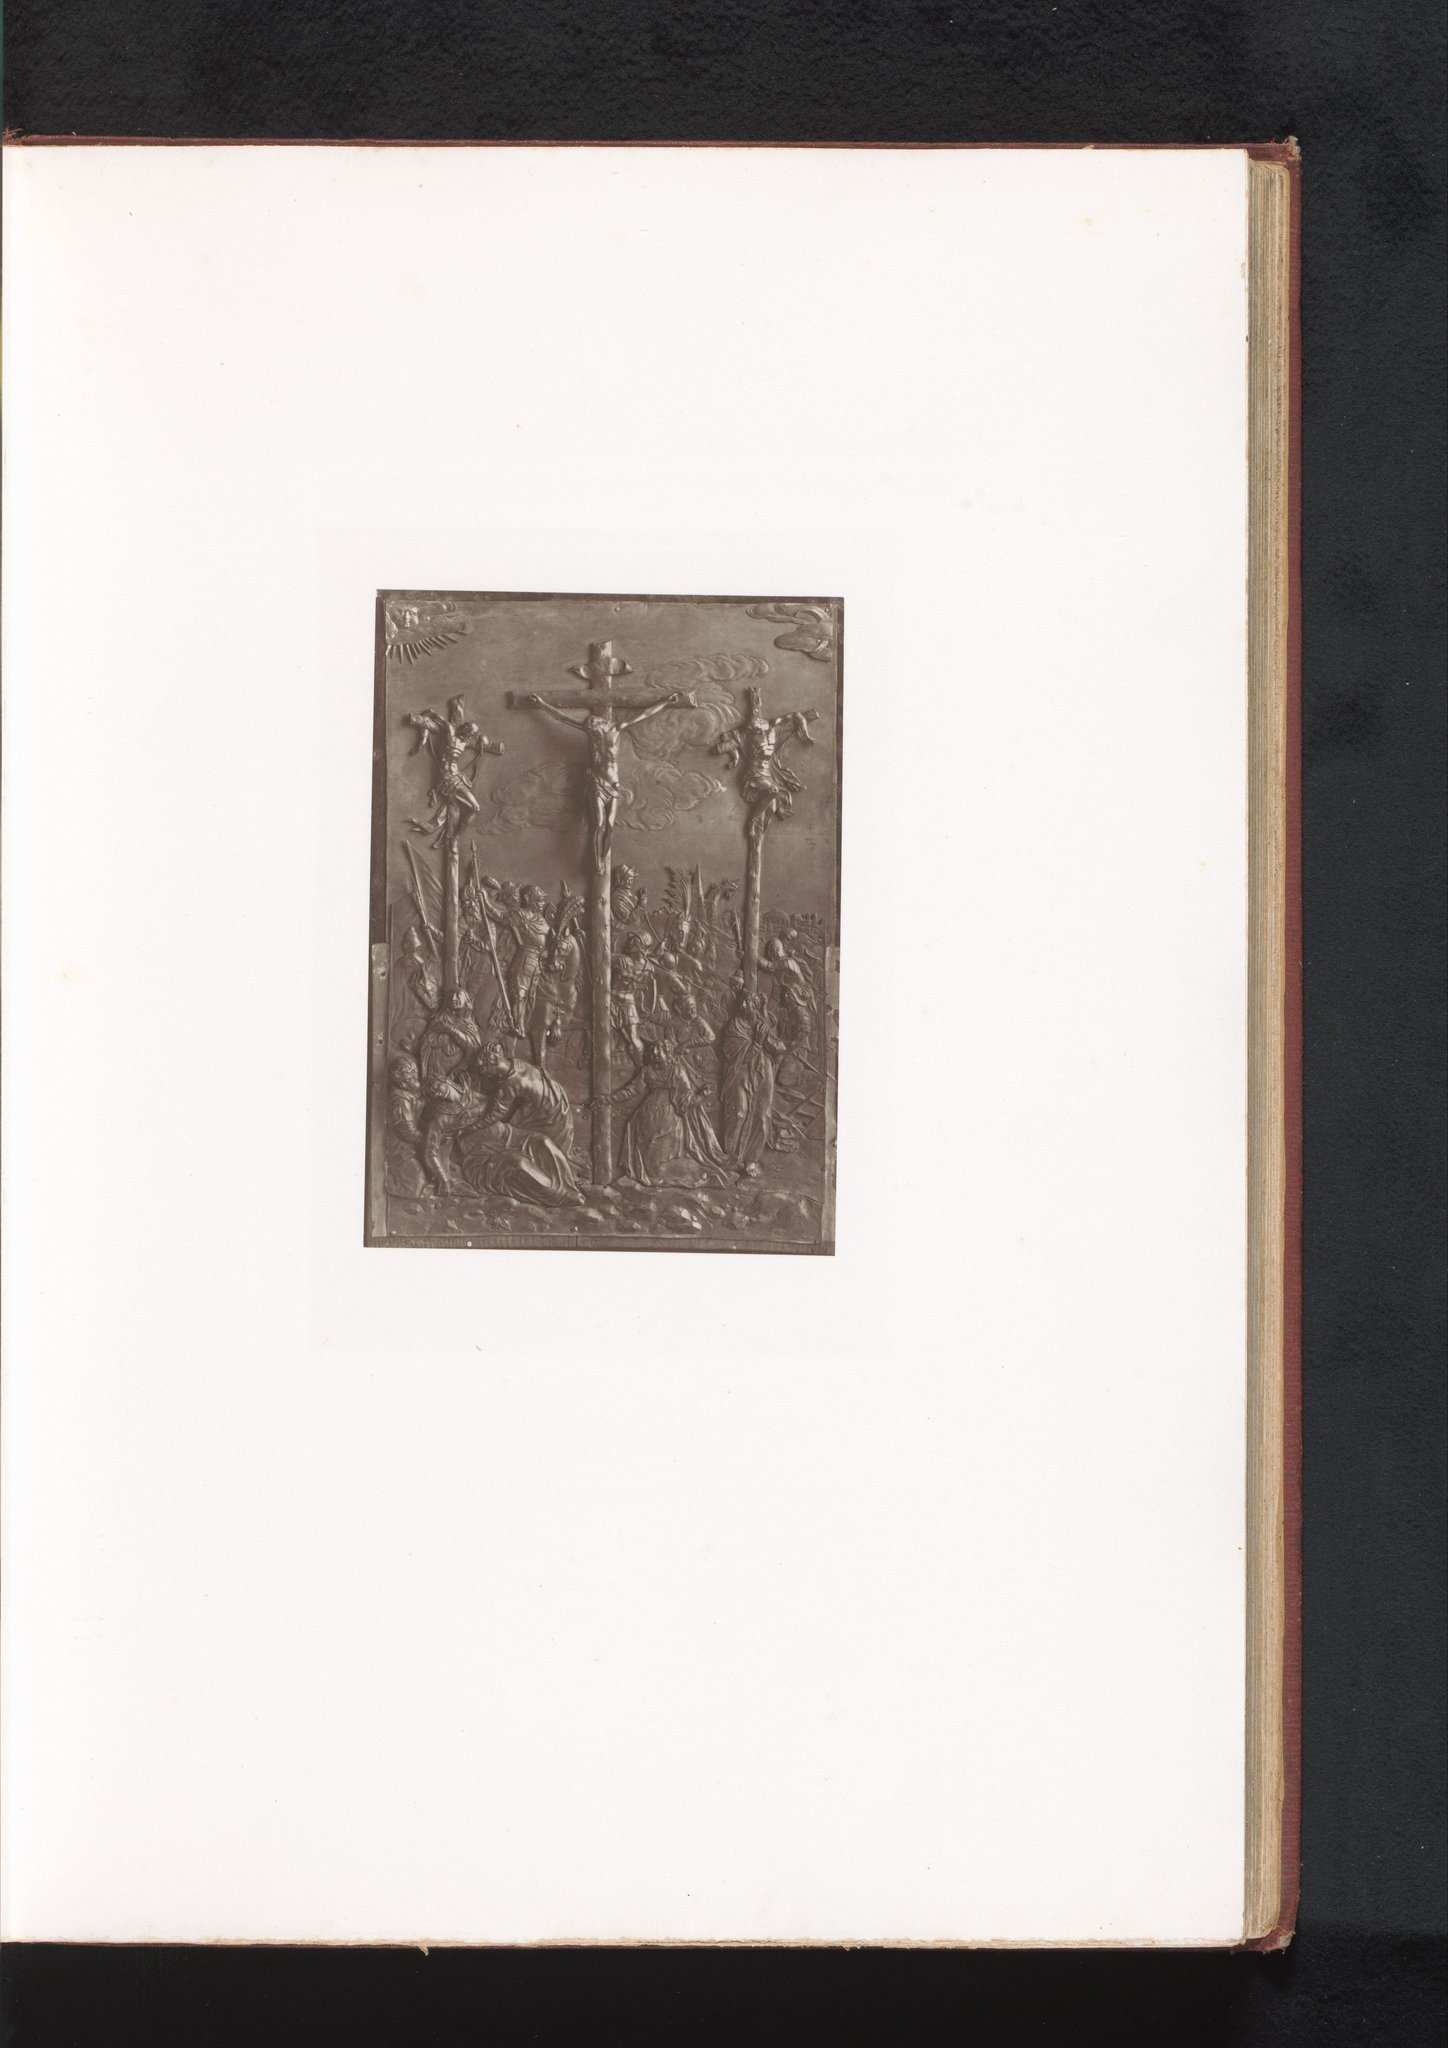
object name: page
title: Metalen reliëf opgesteld tijdens de Exposition Rétrospective van 1873 in Tours, Frankrijk, afgebeeld de kruisiging van Christus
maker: gabriel blaise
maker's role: printer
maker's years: 1827-1897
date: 1873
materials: paper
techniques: woodburytype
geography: tours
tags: dish, plate, saucer, temporary exhibition, 'salon'